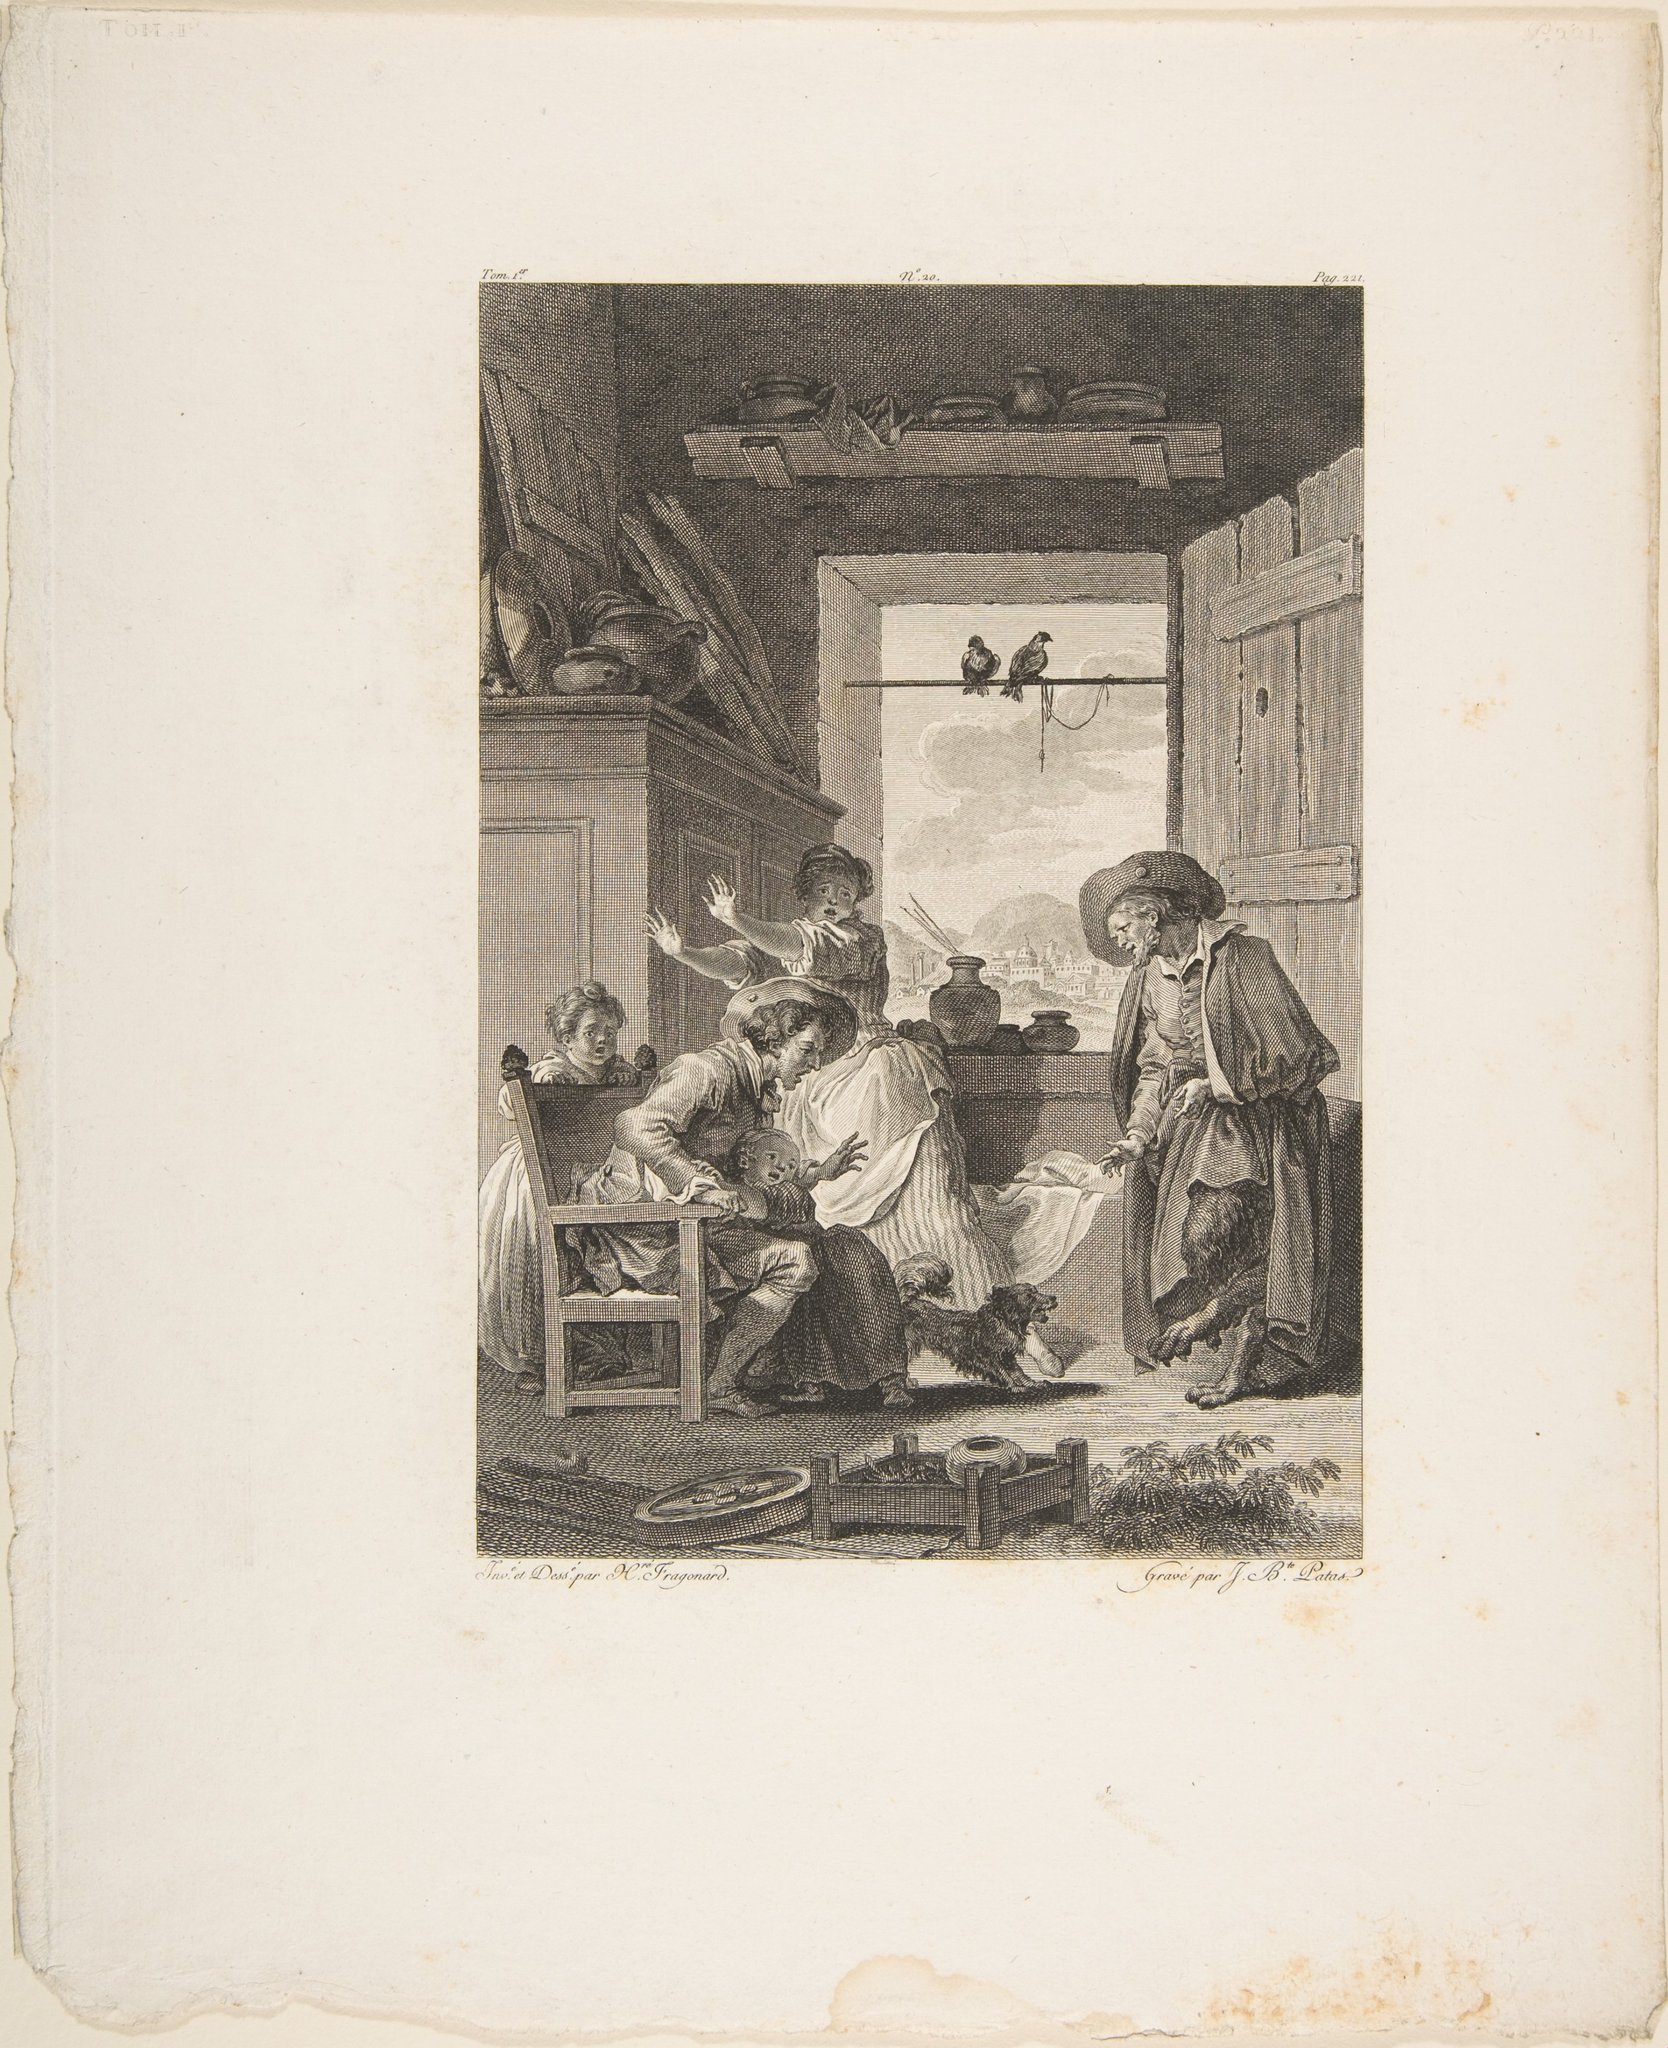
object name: print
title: Belphegor, from Contes et nouvelles en vers par Jean de La Fontaine. A Paris, de l'imprimerie de P. Didot, l'an III de la République, 1795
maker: jean-baptiste patas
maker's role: artist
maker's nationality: french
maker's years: 1744-1802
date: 1795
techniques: engraving, etching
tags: birds,windows,fear,girls,men,women,dogs